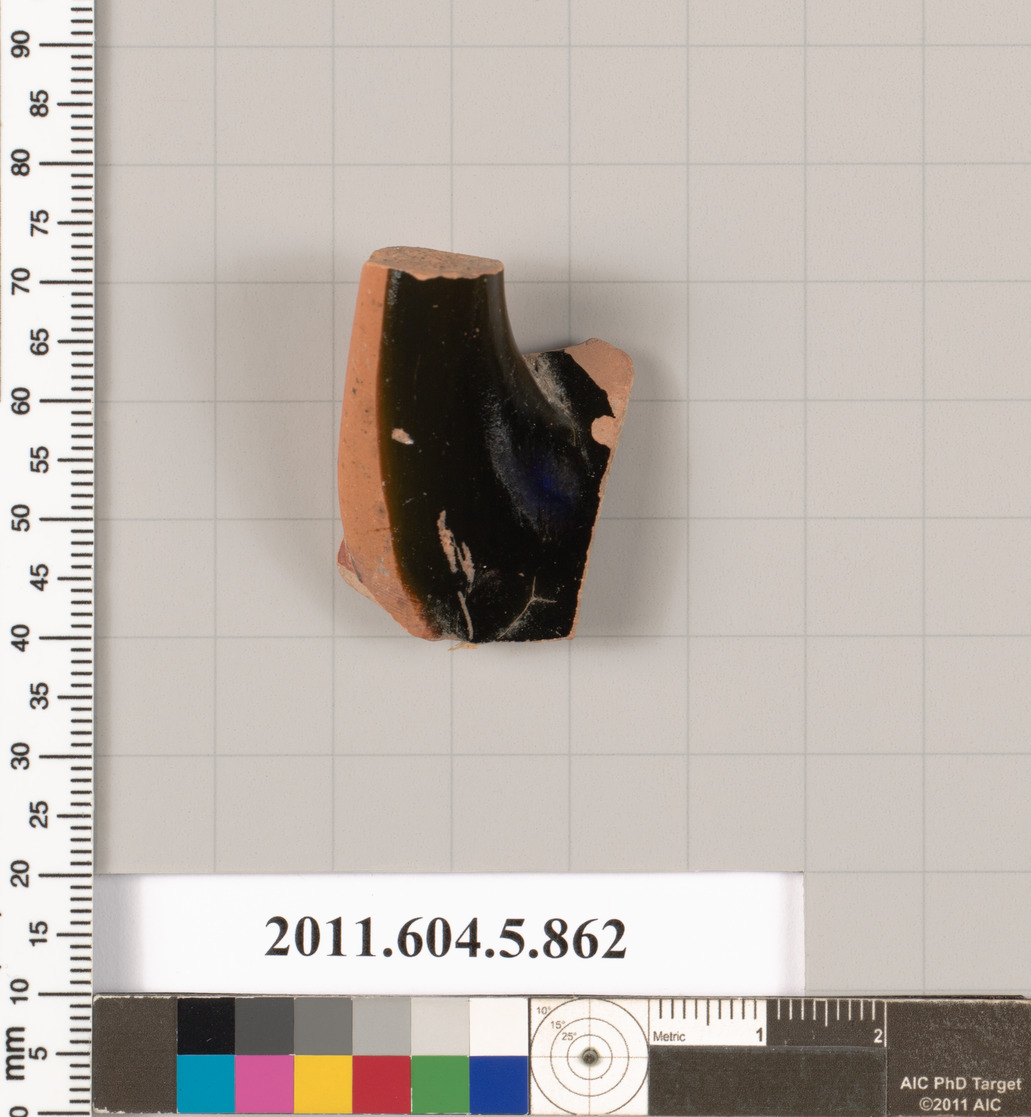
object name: kylix fragment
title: Terracotta fragment of a kylix (drinking cup)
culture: greek, attic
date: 600-401 BCE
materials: terracotta